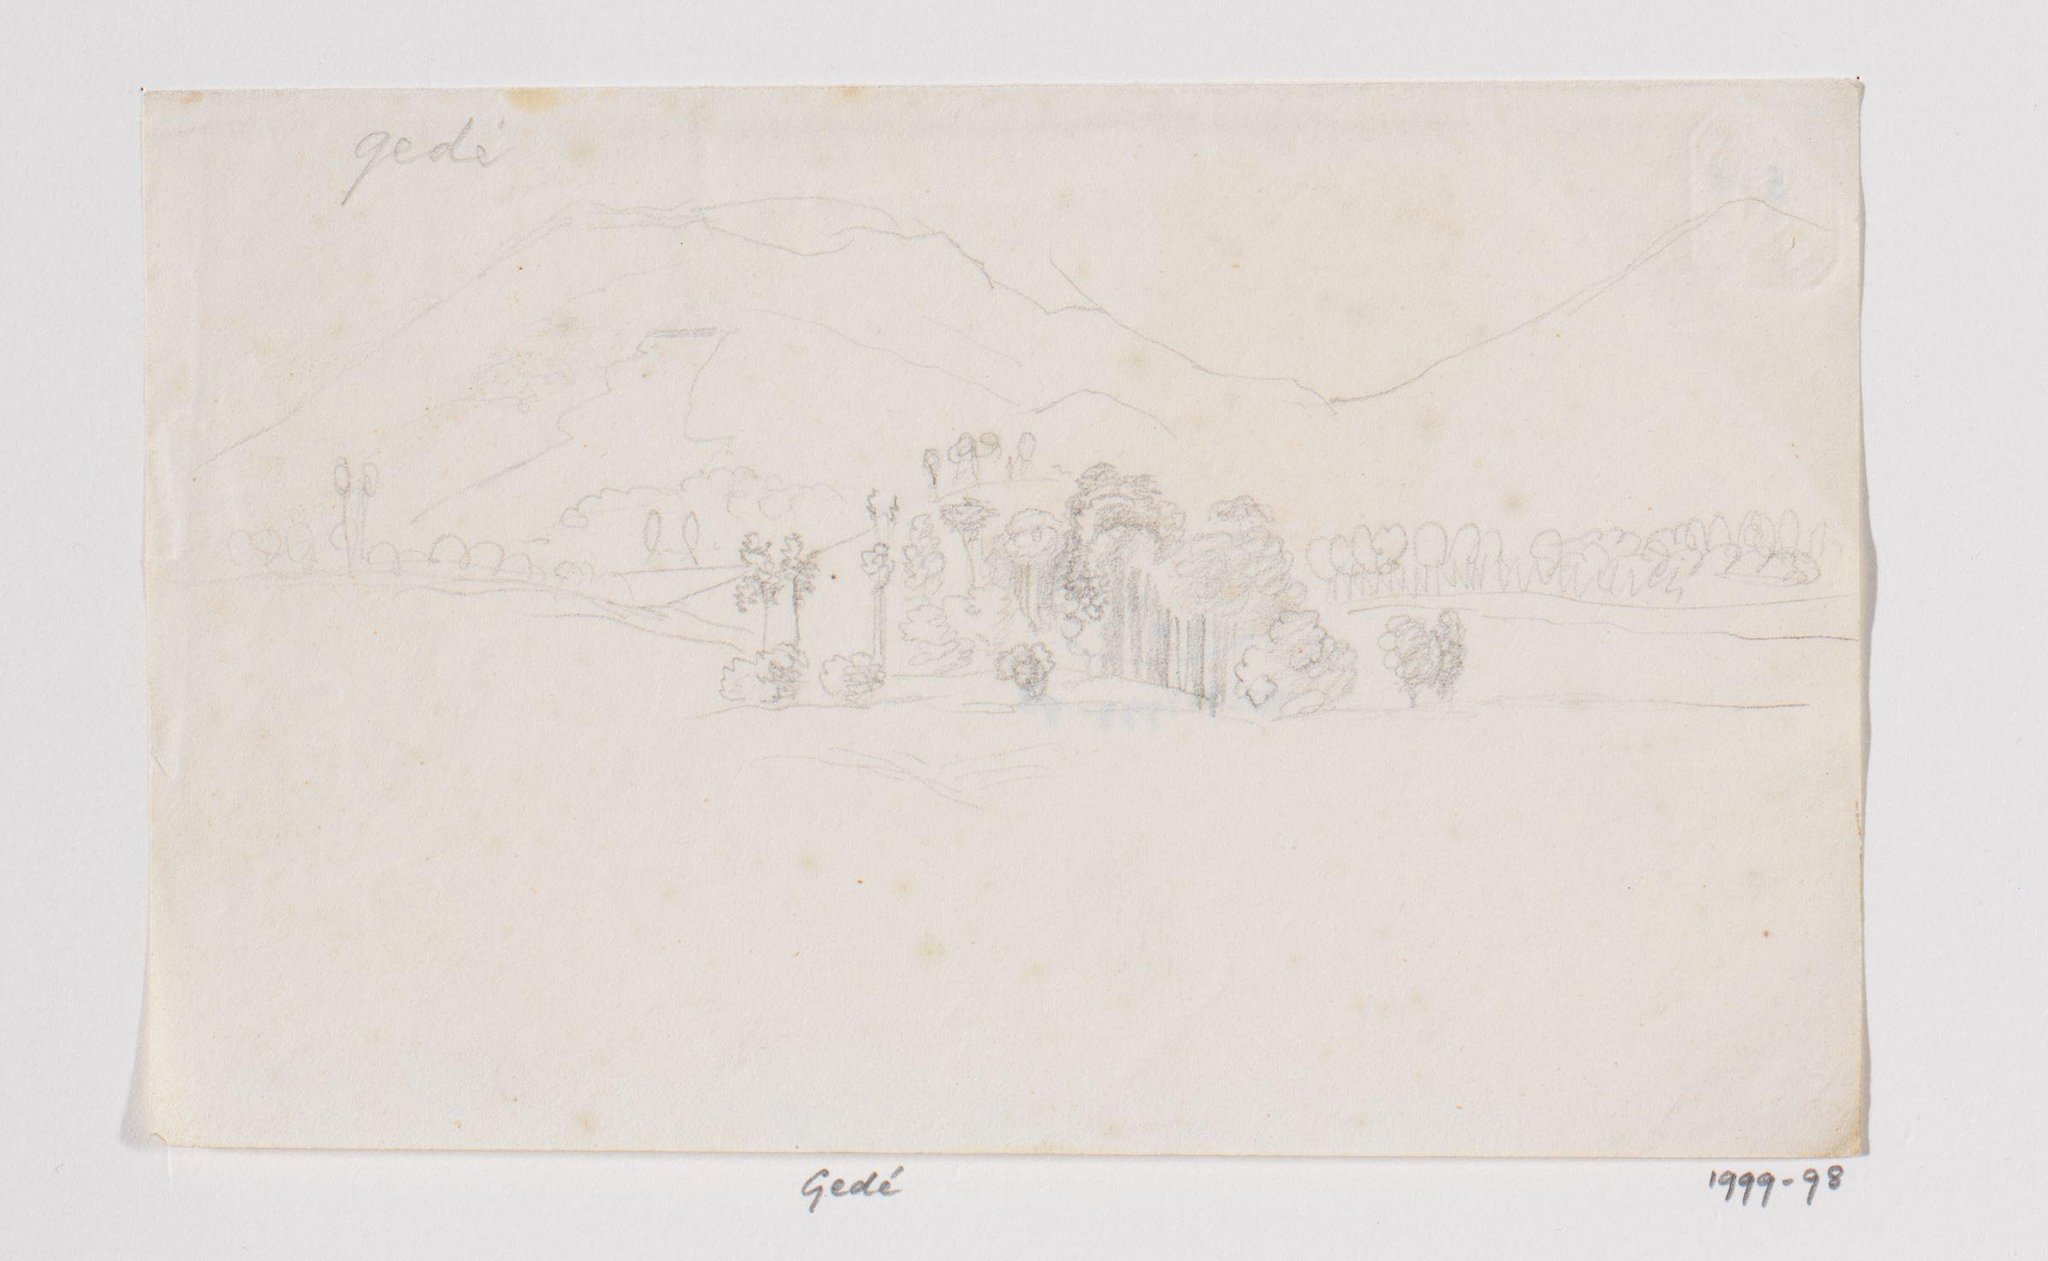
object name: drawing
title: West-Javaans landschap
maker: adrianus johannes bik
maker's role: draughtsman, print maker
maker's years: 1790-1872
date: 1816-1846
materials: chalk, paper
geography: west java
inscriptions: inscription: ‘Gedé’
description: artikel over deze collectie in Bulletin van het Rijksmuseum 49 [2001], nr. 4, pp 342 e.v.